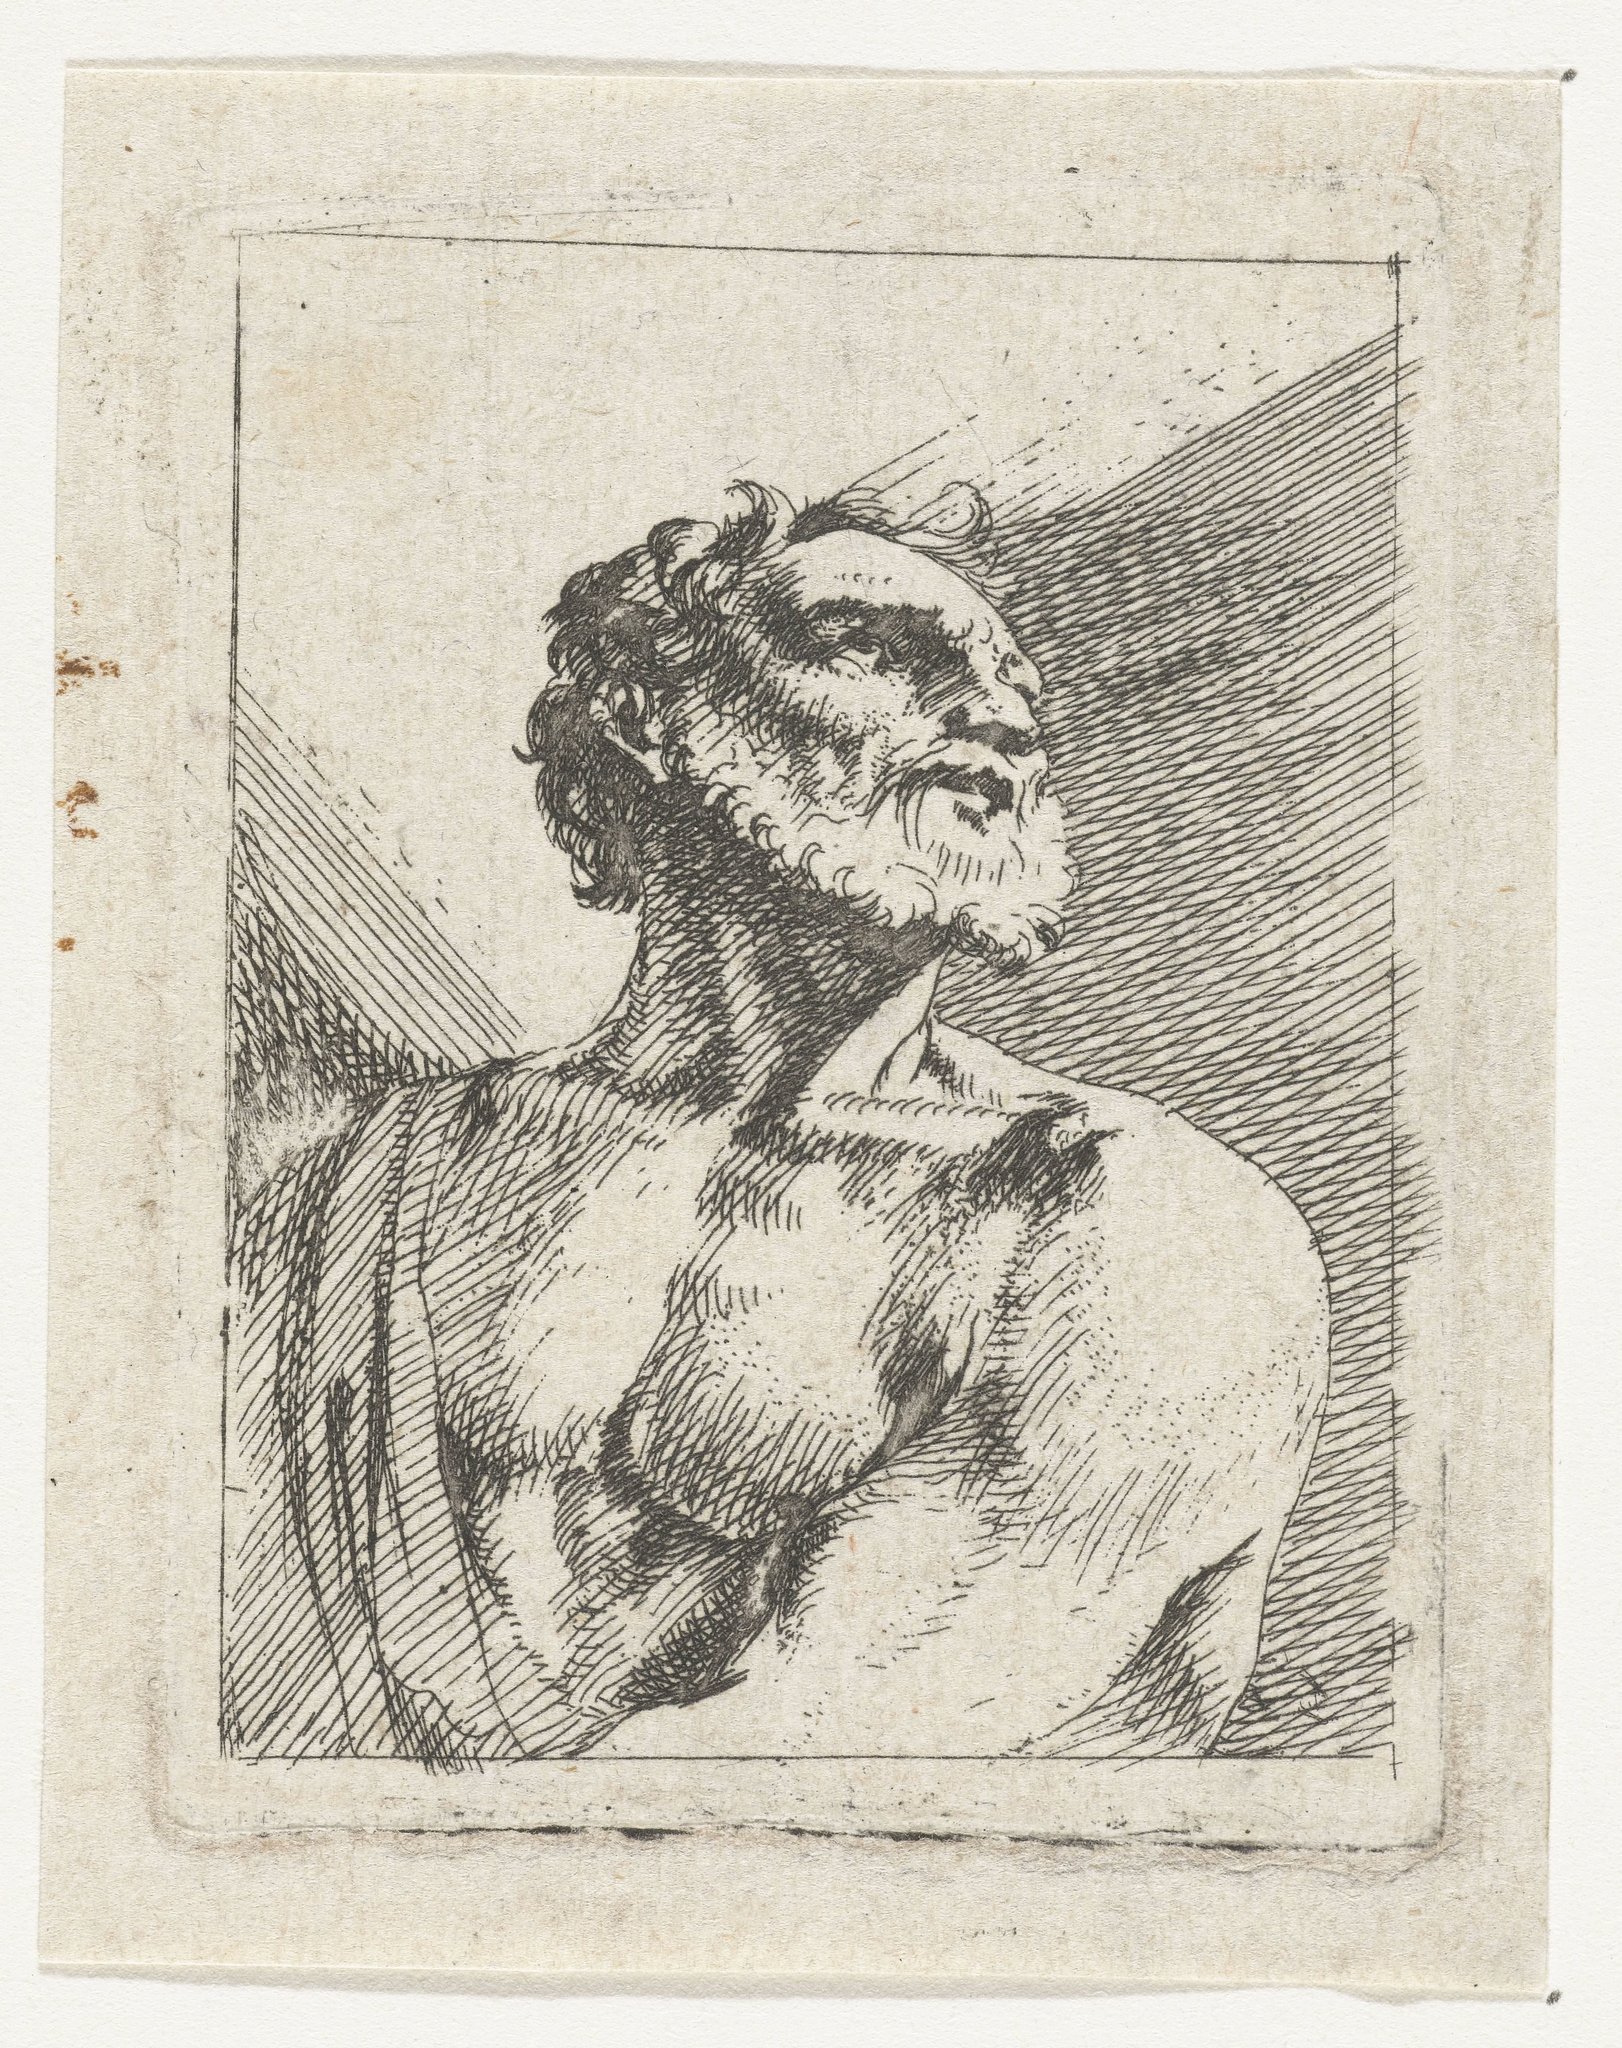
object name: print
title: Tronies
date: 1626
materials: paper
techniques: etching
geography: augsburg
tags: head (human)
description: Gebaseerd op de verschillende staten van de titelprent van deze serie (voor tweede staat zie RP-P-2002-384), is deze serie in ieder geval vier keer uitgeven. Voor het eerst in 1626 (jaartal vermeld op titelprent) en vervolgens in ieder geval drie keer door de Augsburgse uitgever Jeremias Wolf, die van 1686 tot 1724 actief was. Het is onduidelijk tot welke uitgave dit exemplaar behoort.